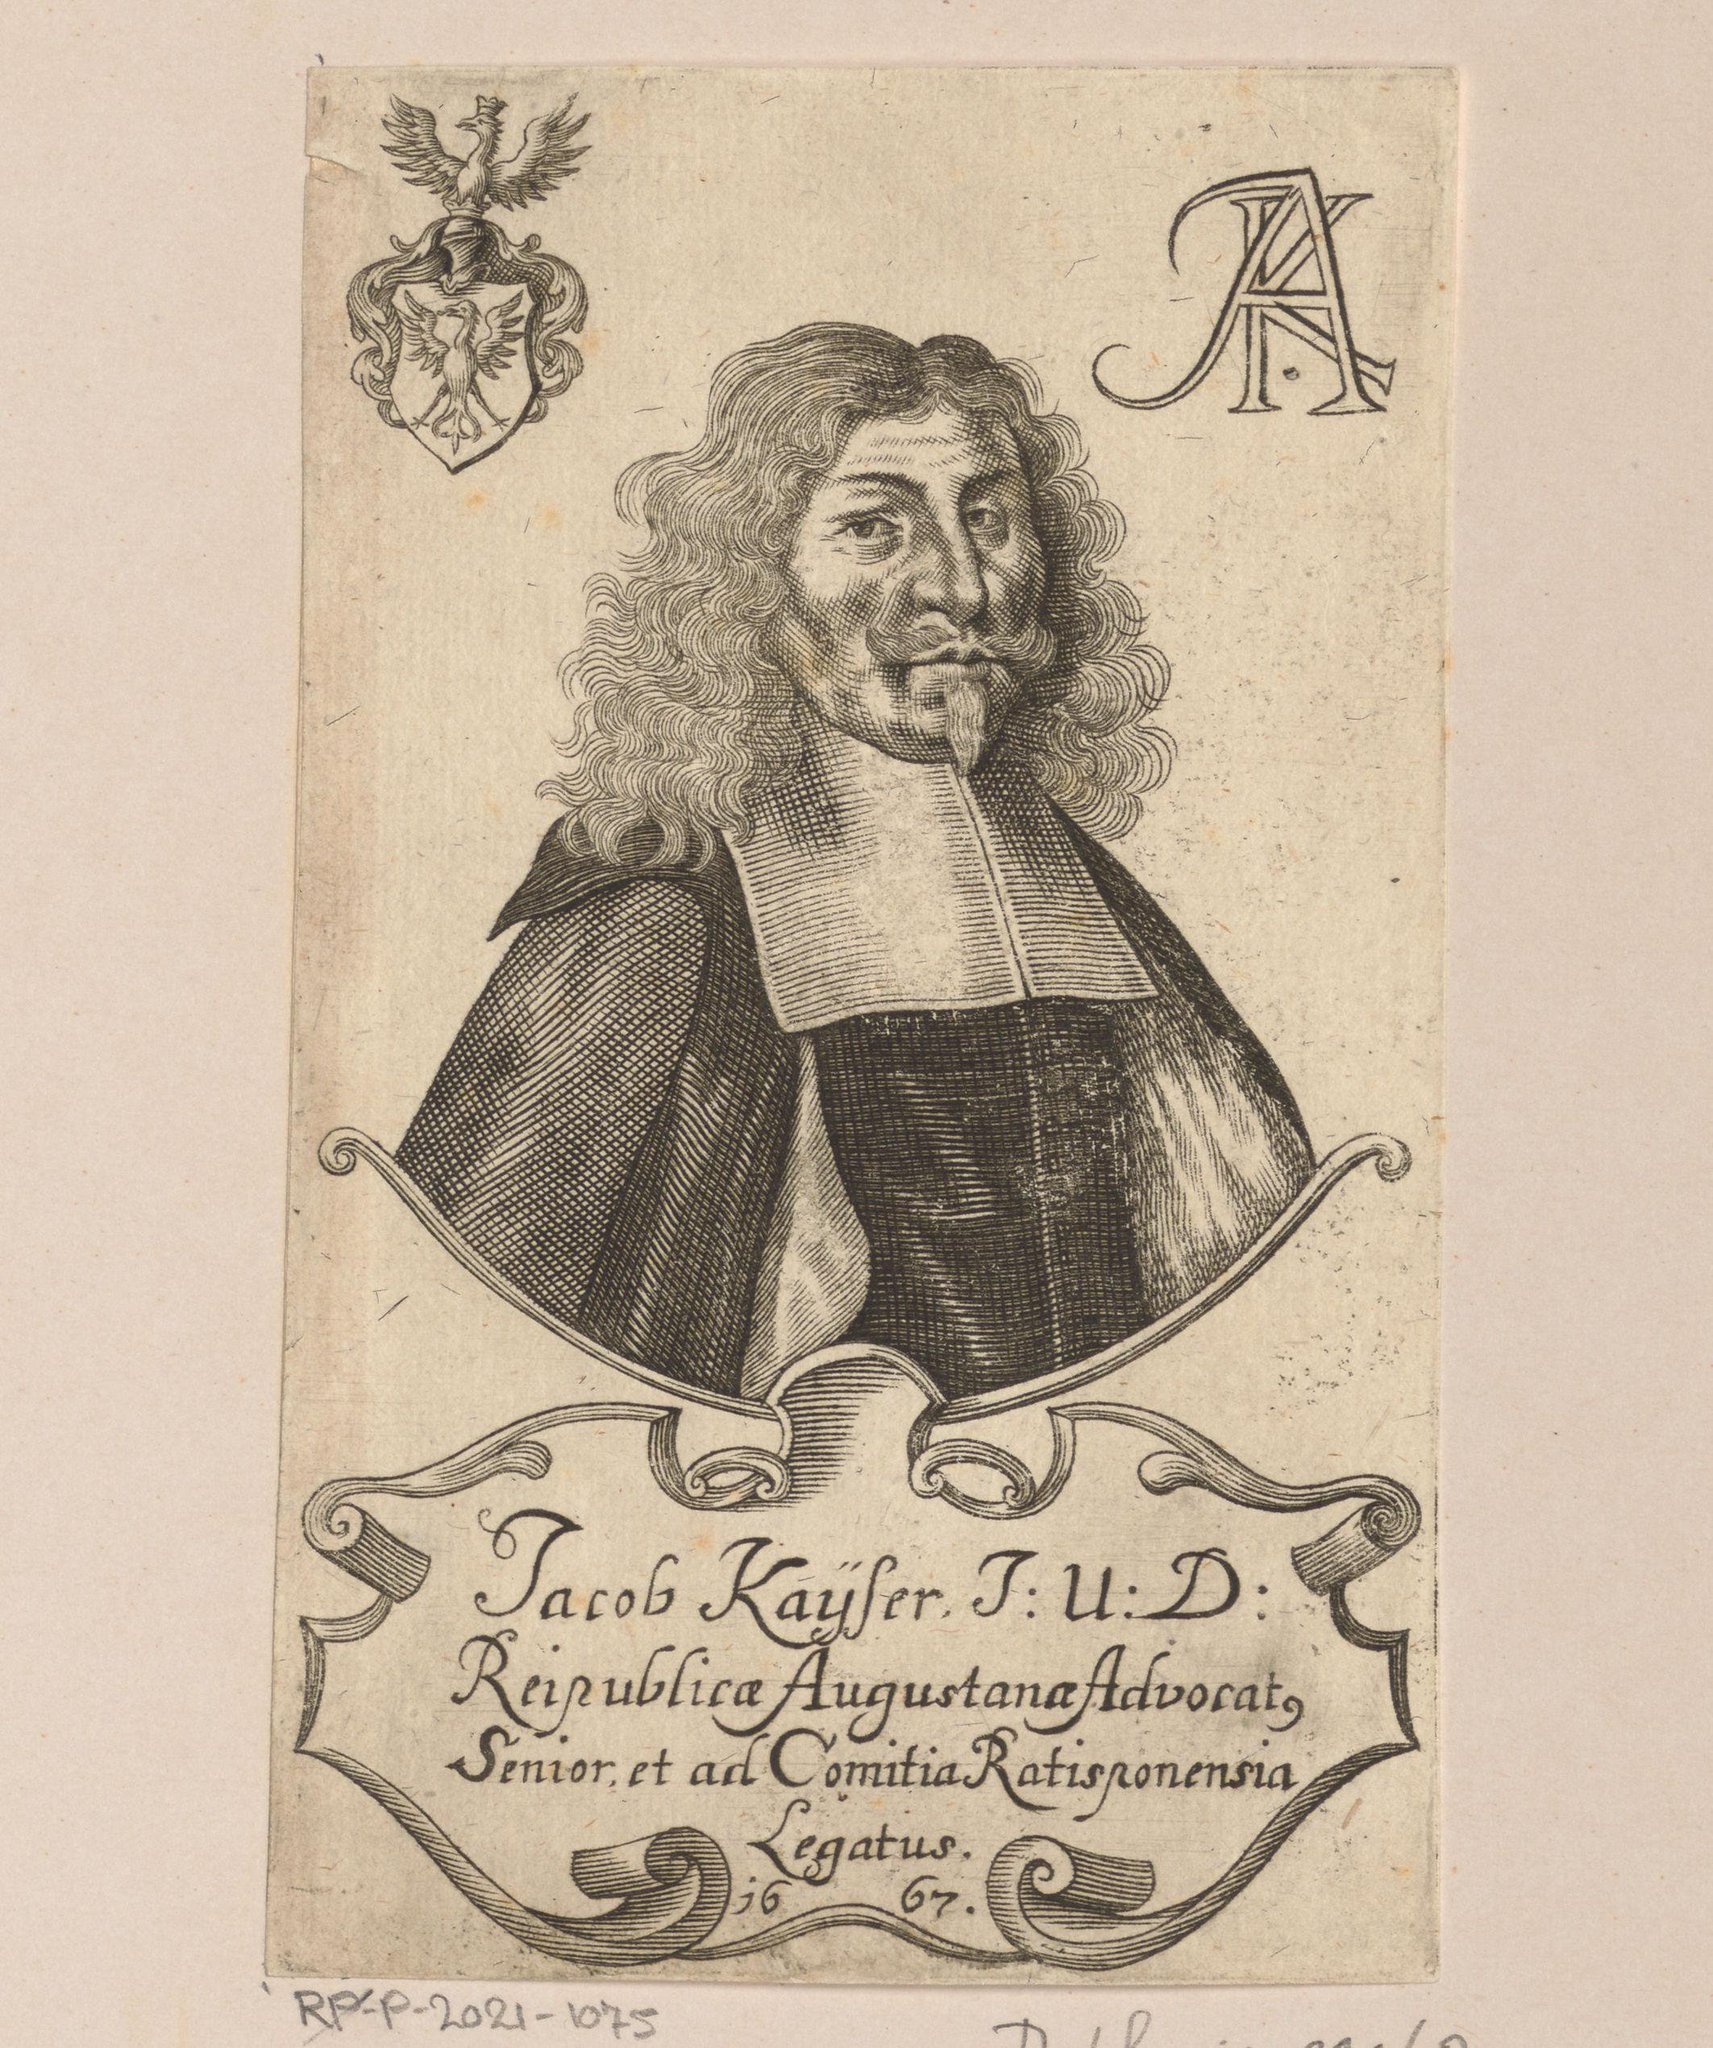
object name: print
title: Portret van Jacob Kayser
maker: Anonymous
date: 1667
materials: paper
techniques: engraving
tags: historical persons, armorial bearing, heraldry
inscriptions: date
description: Links naast het portret zijn wapenschild.